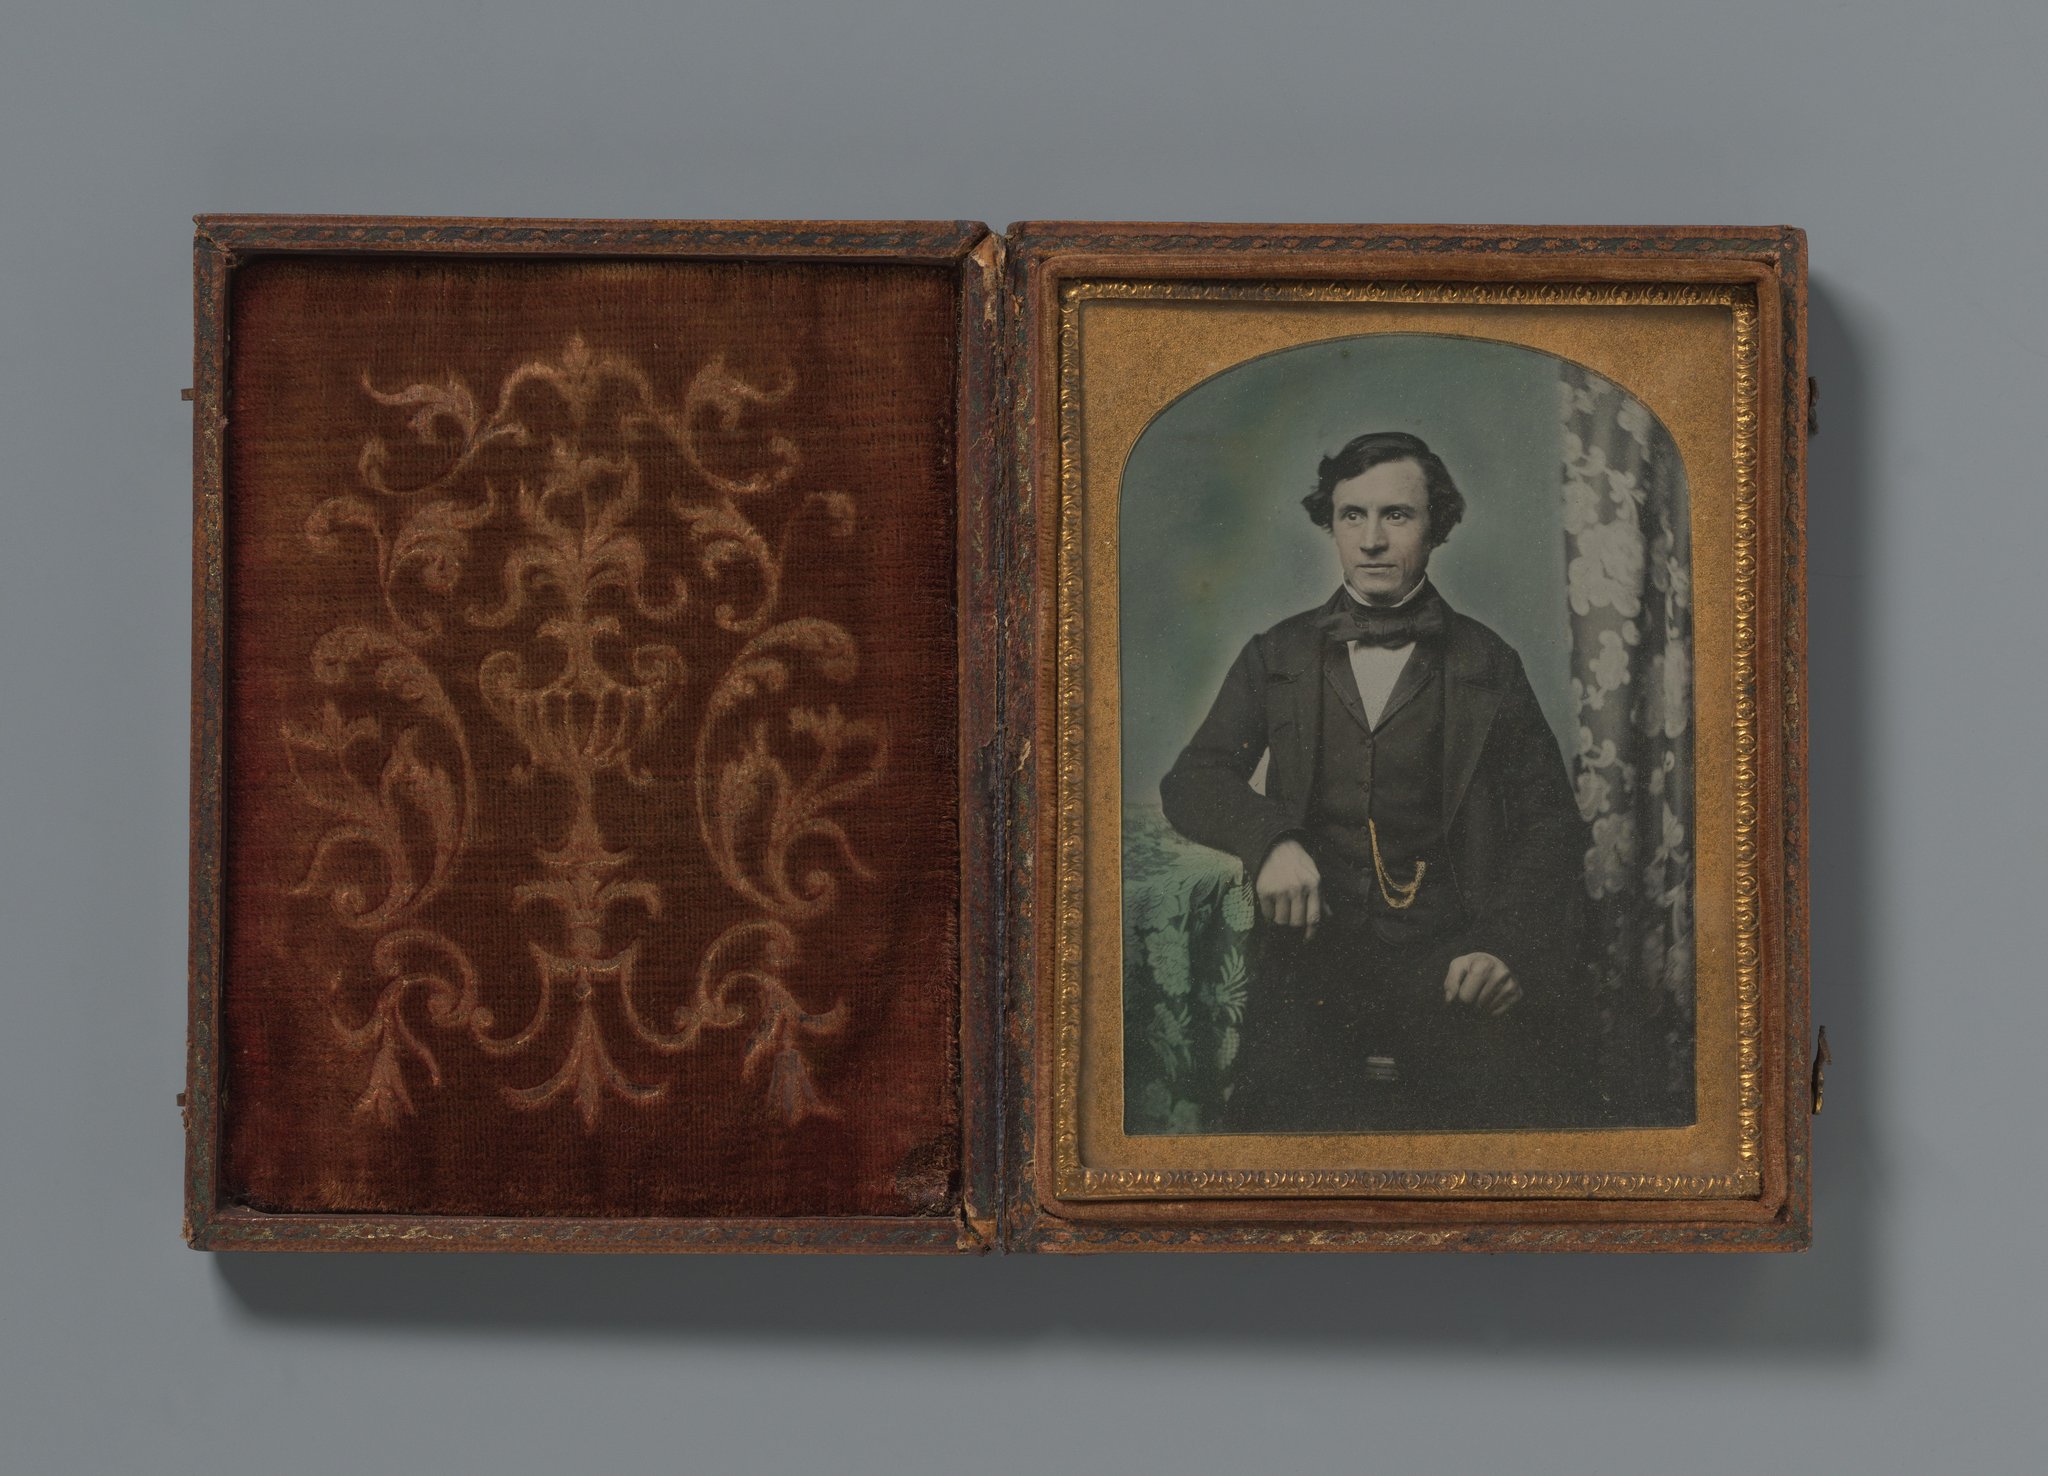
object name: photograph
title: Portret van een onbekende jongeman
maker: Anonymous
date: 1855-1870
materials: glass, metal, velvet, wood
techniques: ambrotype, hand coloring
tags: historical persons, youth, adolescent